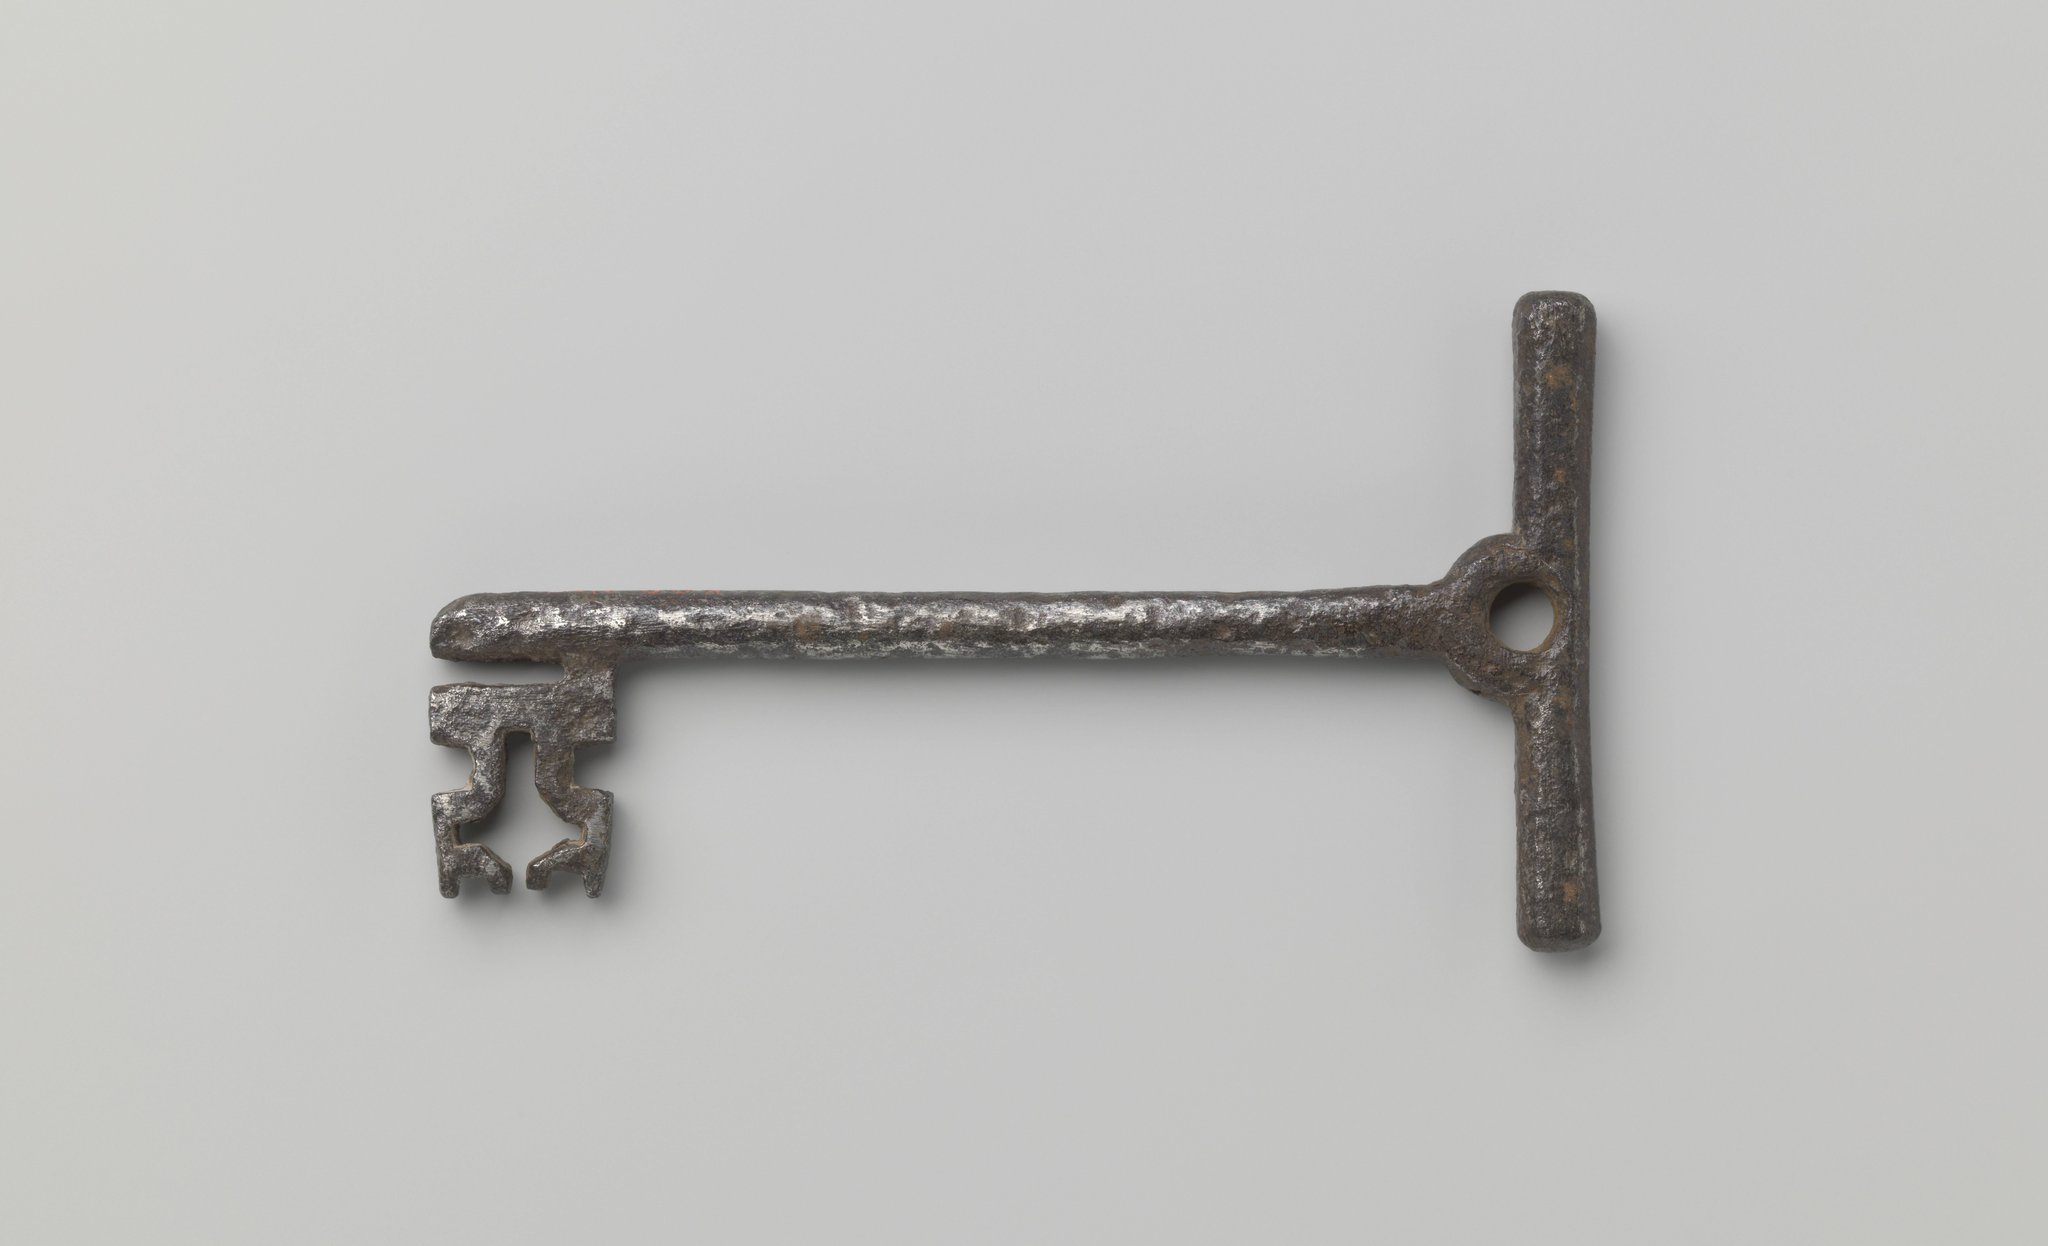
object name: key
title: Sleutel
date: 1600-1699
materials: iron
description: Sleutel waarvan de schacht en greep een T vormen met in het snijpunt een oog.